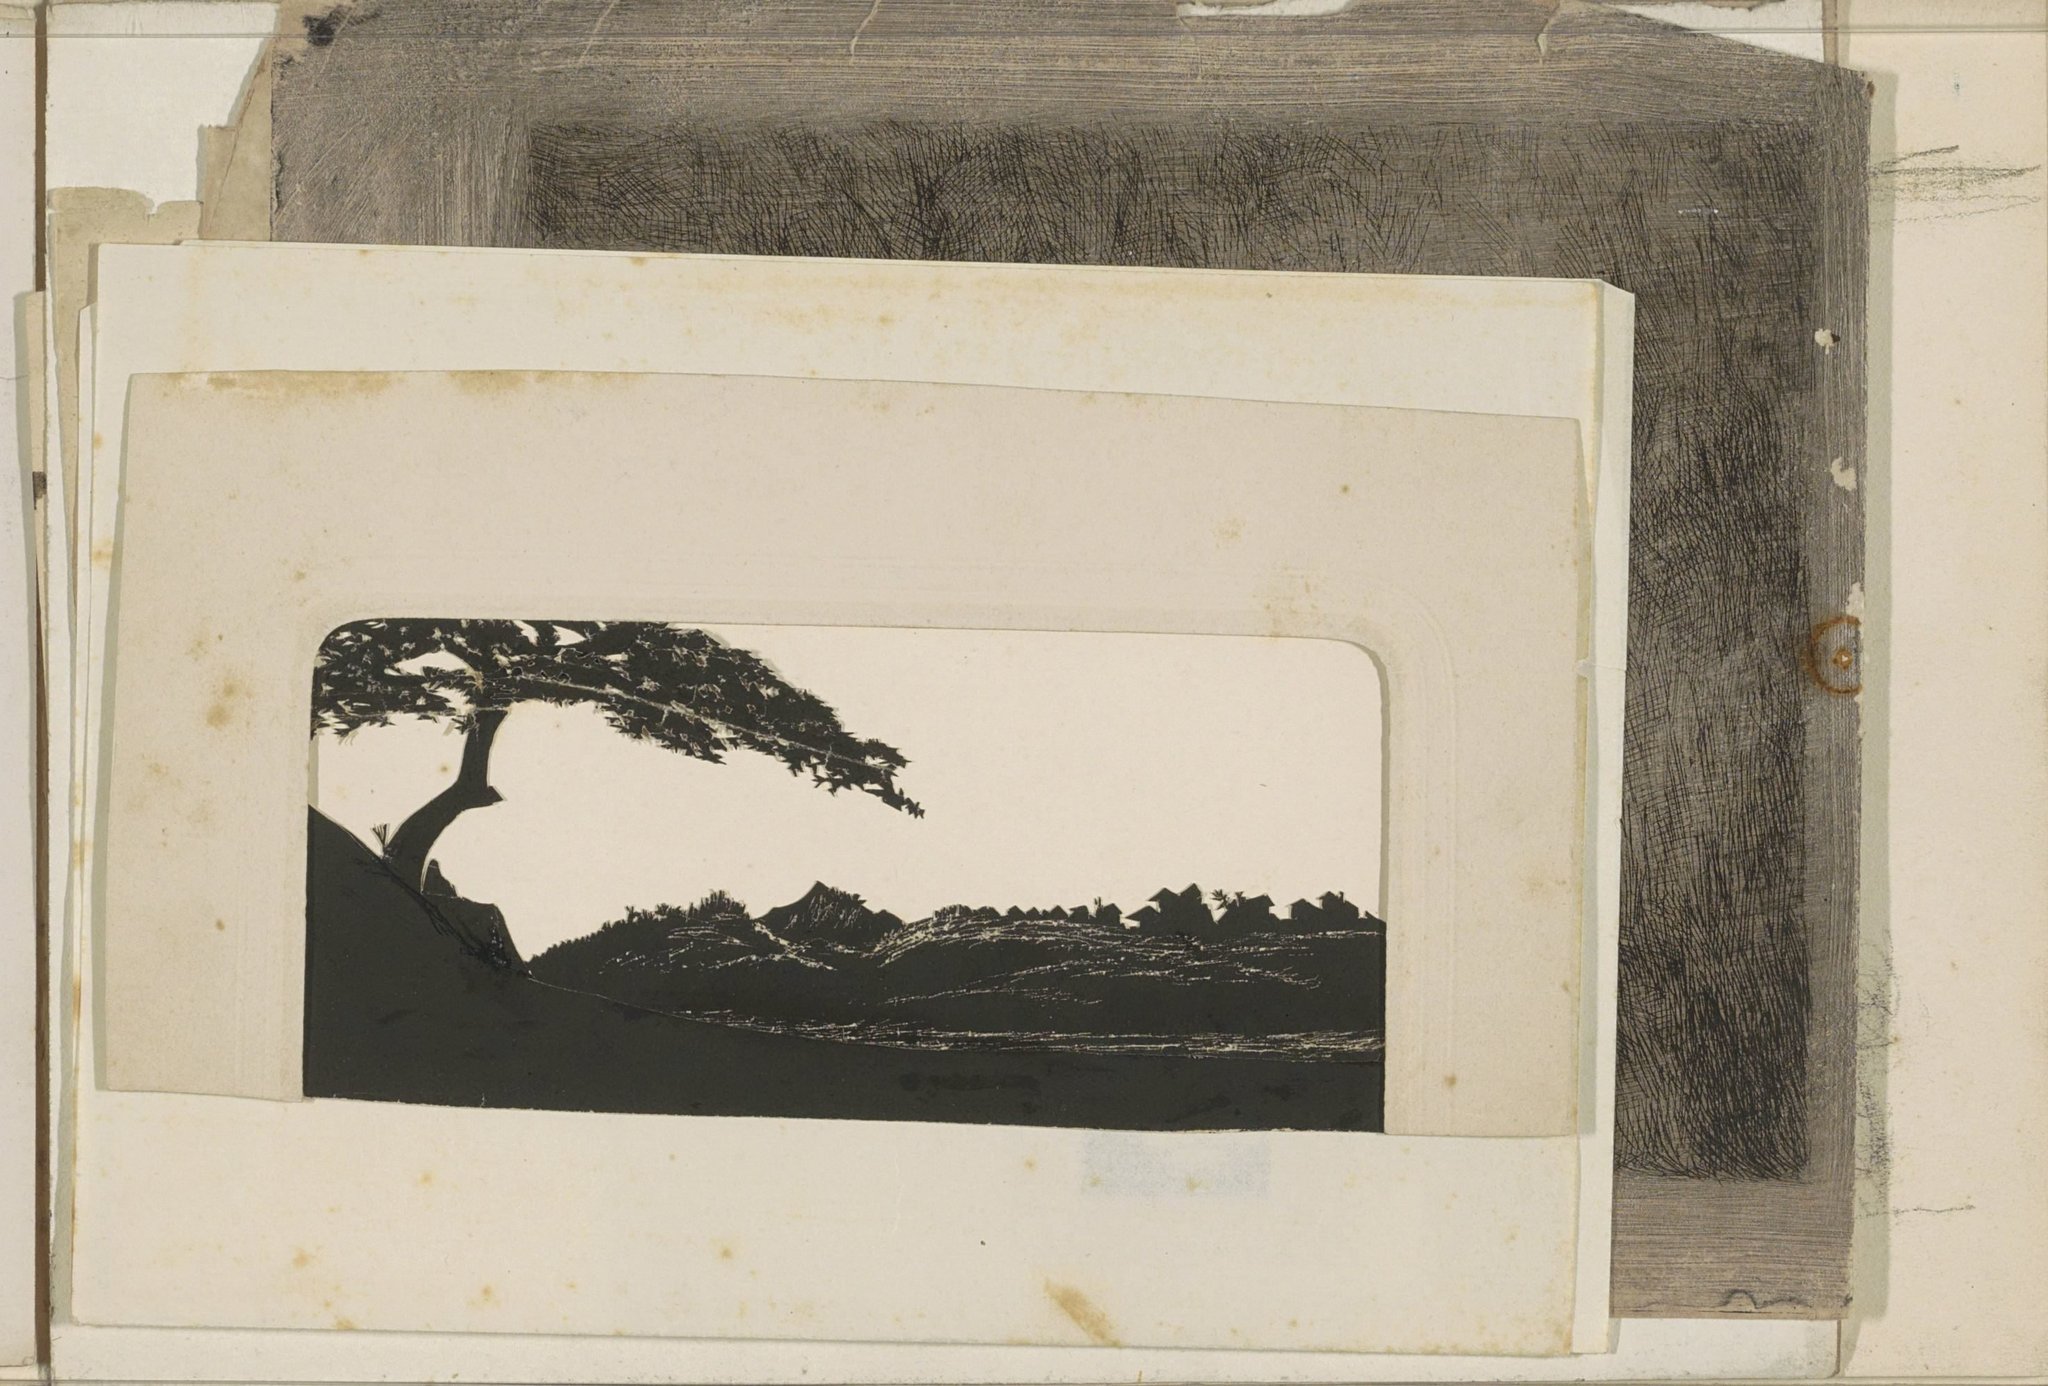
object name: cut paper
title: Heuvellandschap met huizen en een boom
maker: a.a.l. de grammont-hubrecht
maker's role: draughtsman, painter, print maker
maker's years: 1855-1913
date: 1865-1913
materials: paper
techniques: cutting, scoring, snipping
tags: city-view, and landscape with man-made constructions, low hill country, trees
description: Los papierknipkunstwerk tussen pagina 1 en 2 uit een schetsboek met 68 bladen.